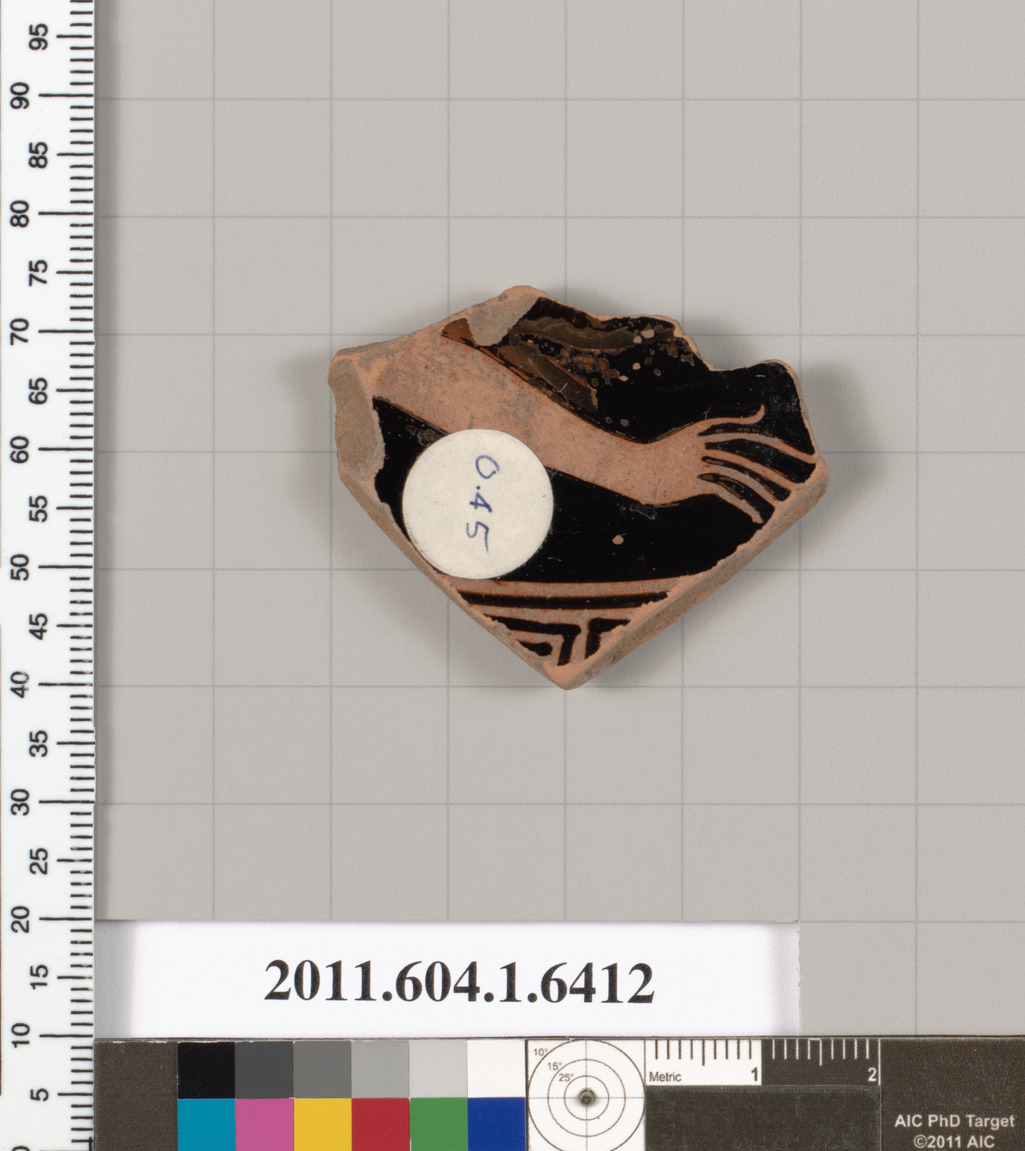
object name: kylix fragment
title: Terracotta fragment of a kylix (drinking cup)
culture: greek, attic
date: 490-480 BCE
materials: terracotta